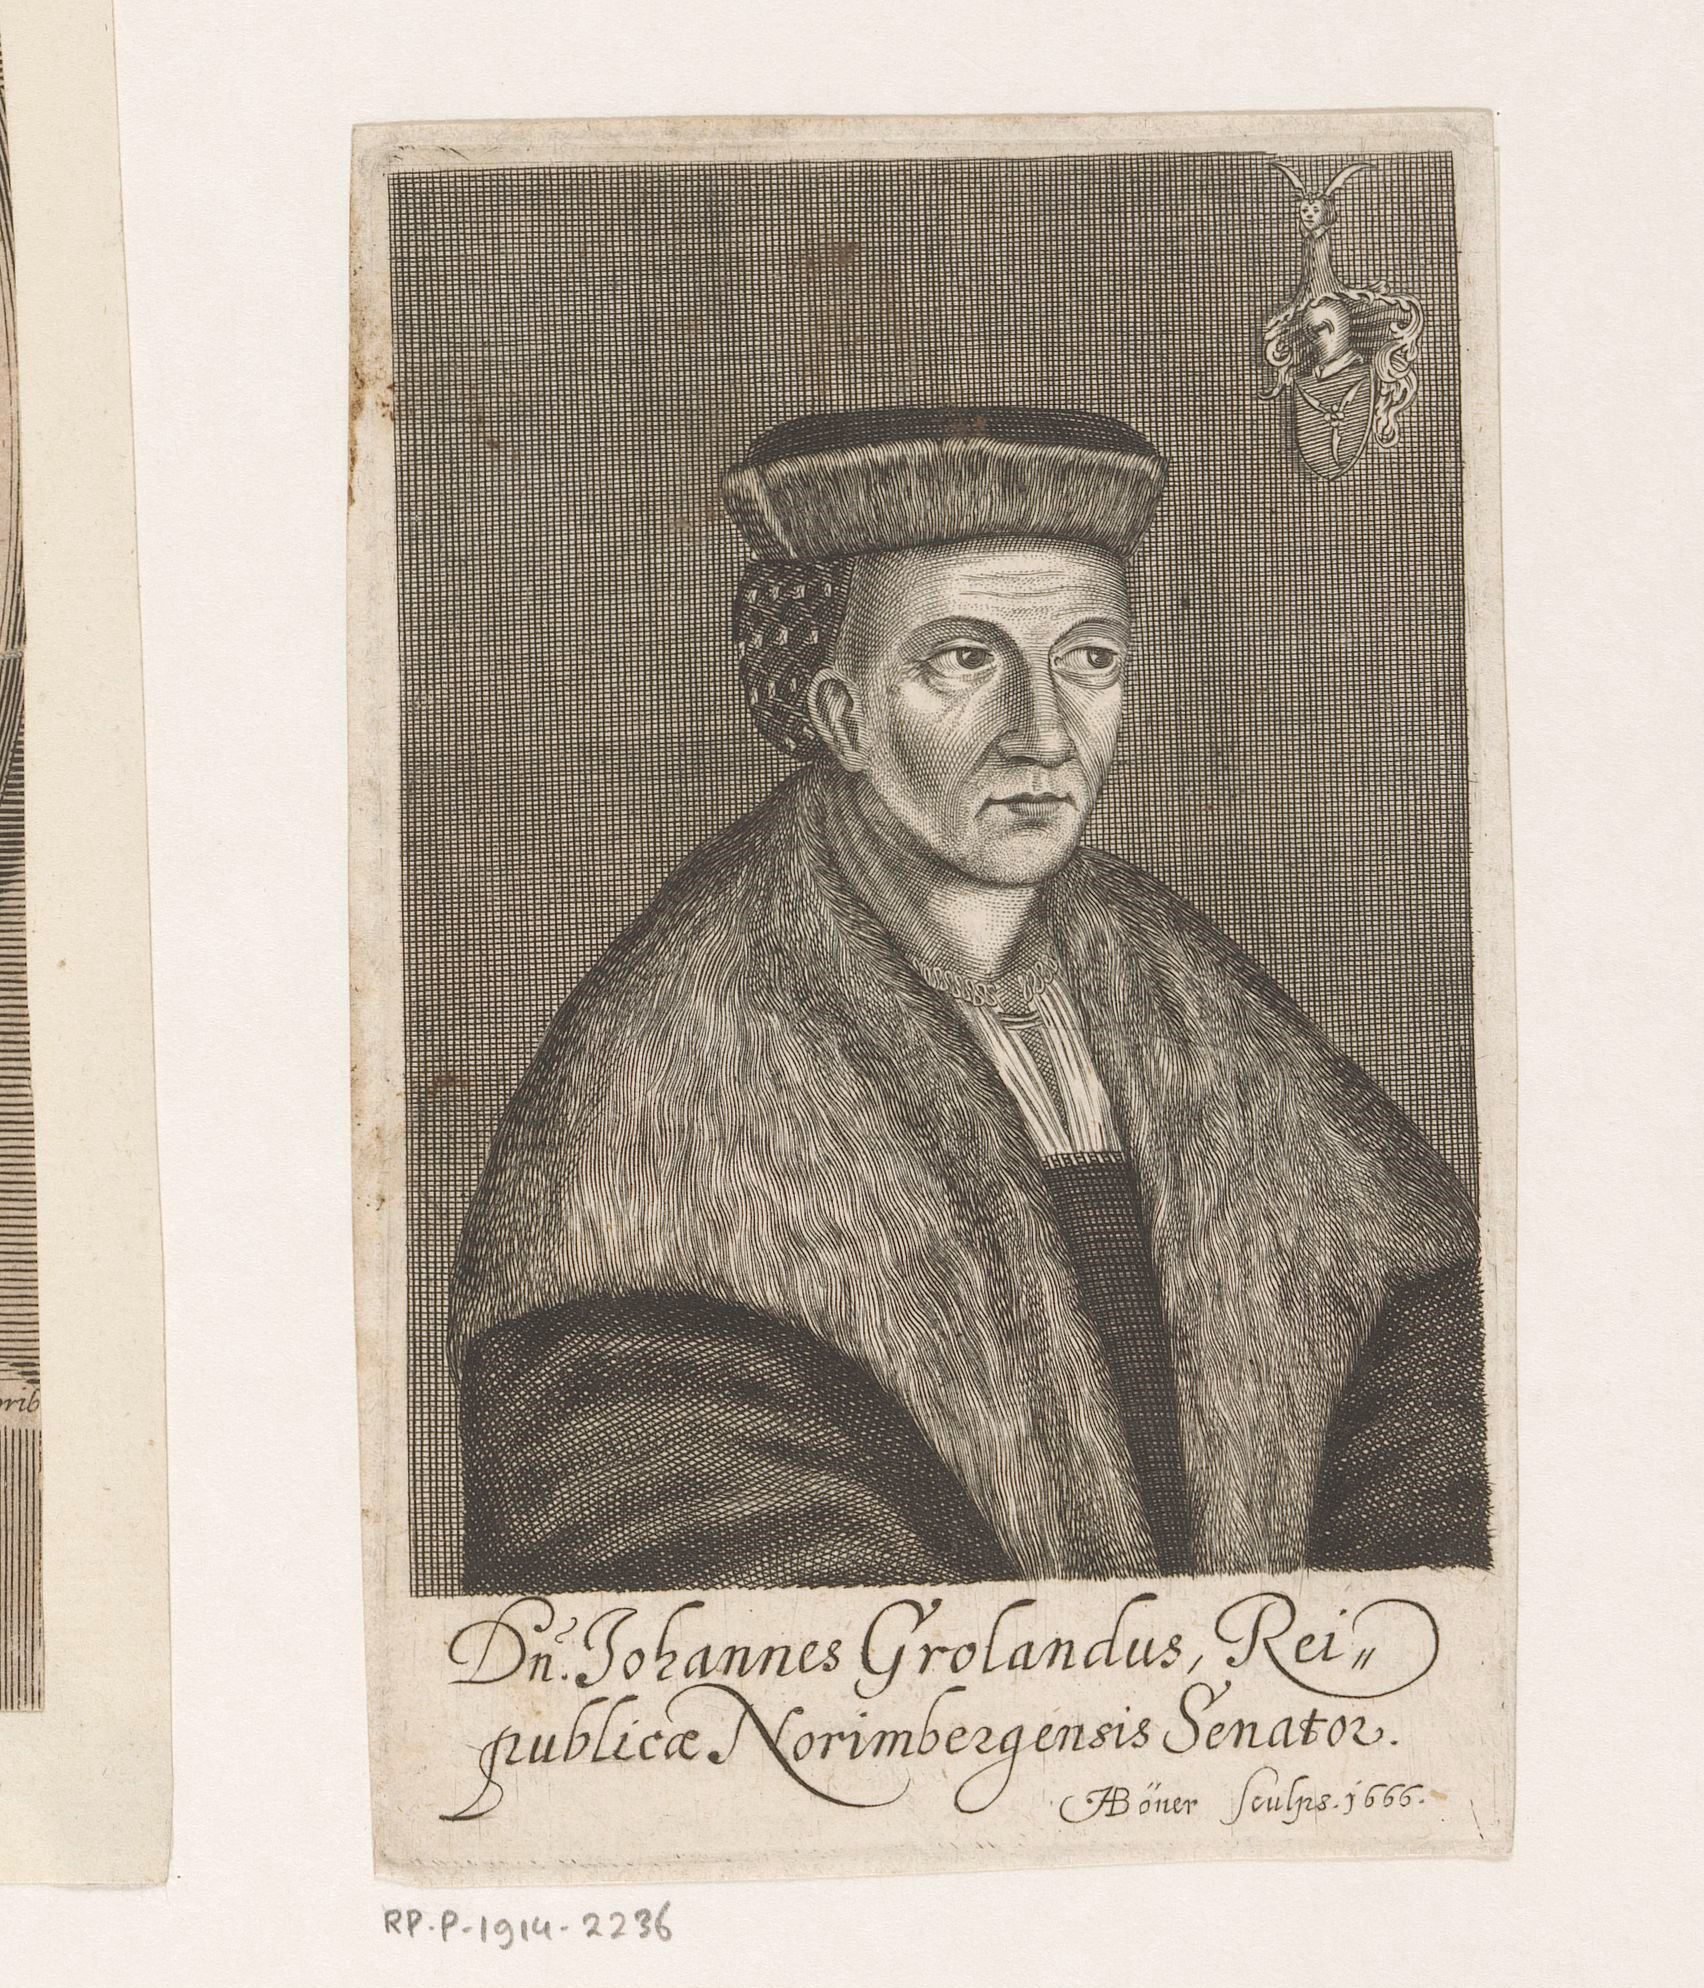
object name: print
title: Portret van Johann Groland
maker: johann alexander böner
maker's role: draughtsman, print maker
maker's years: 1647-1720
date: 1666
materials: paper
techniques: engraving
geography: nuremberg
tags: historical persons, armorial bearing, heraldry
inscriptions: collector's mark: Lugt 2228